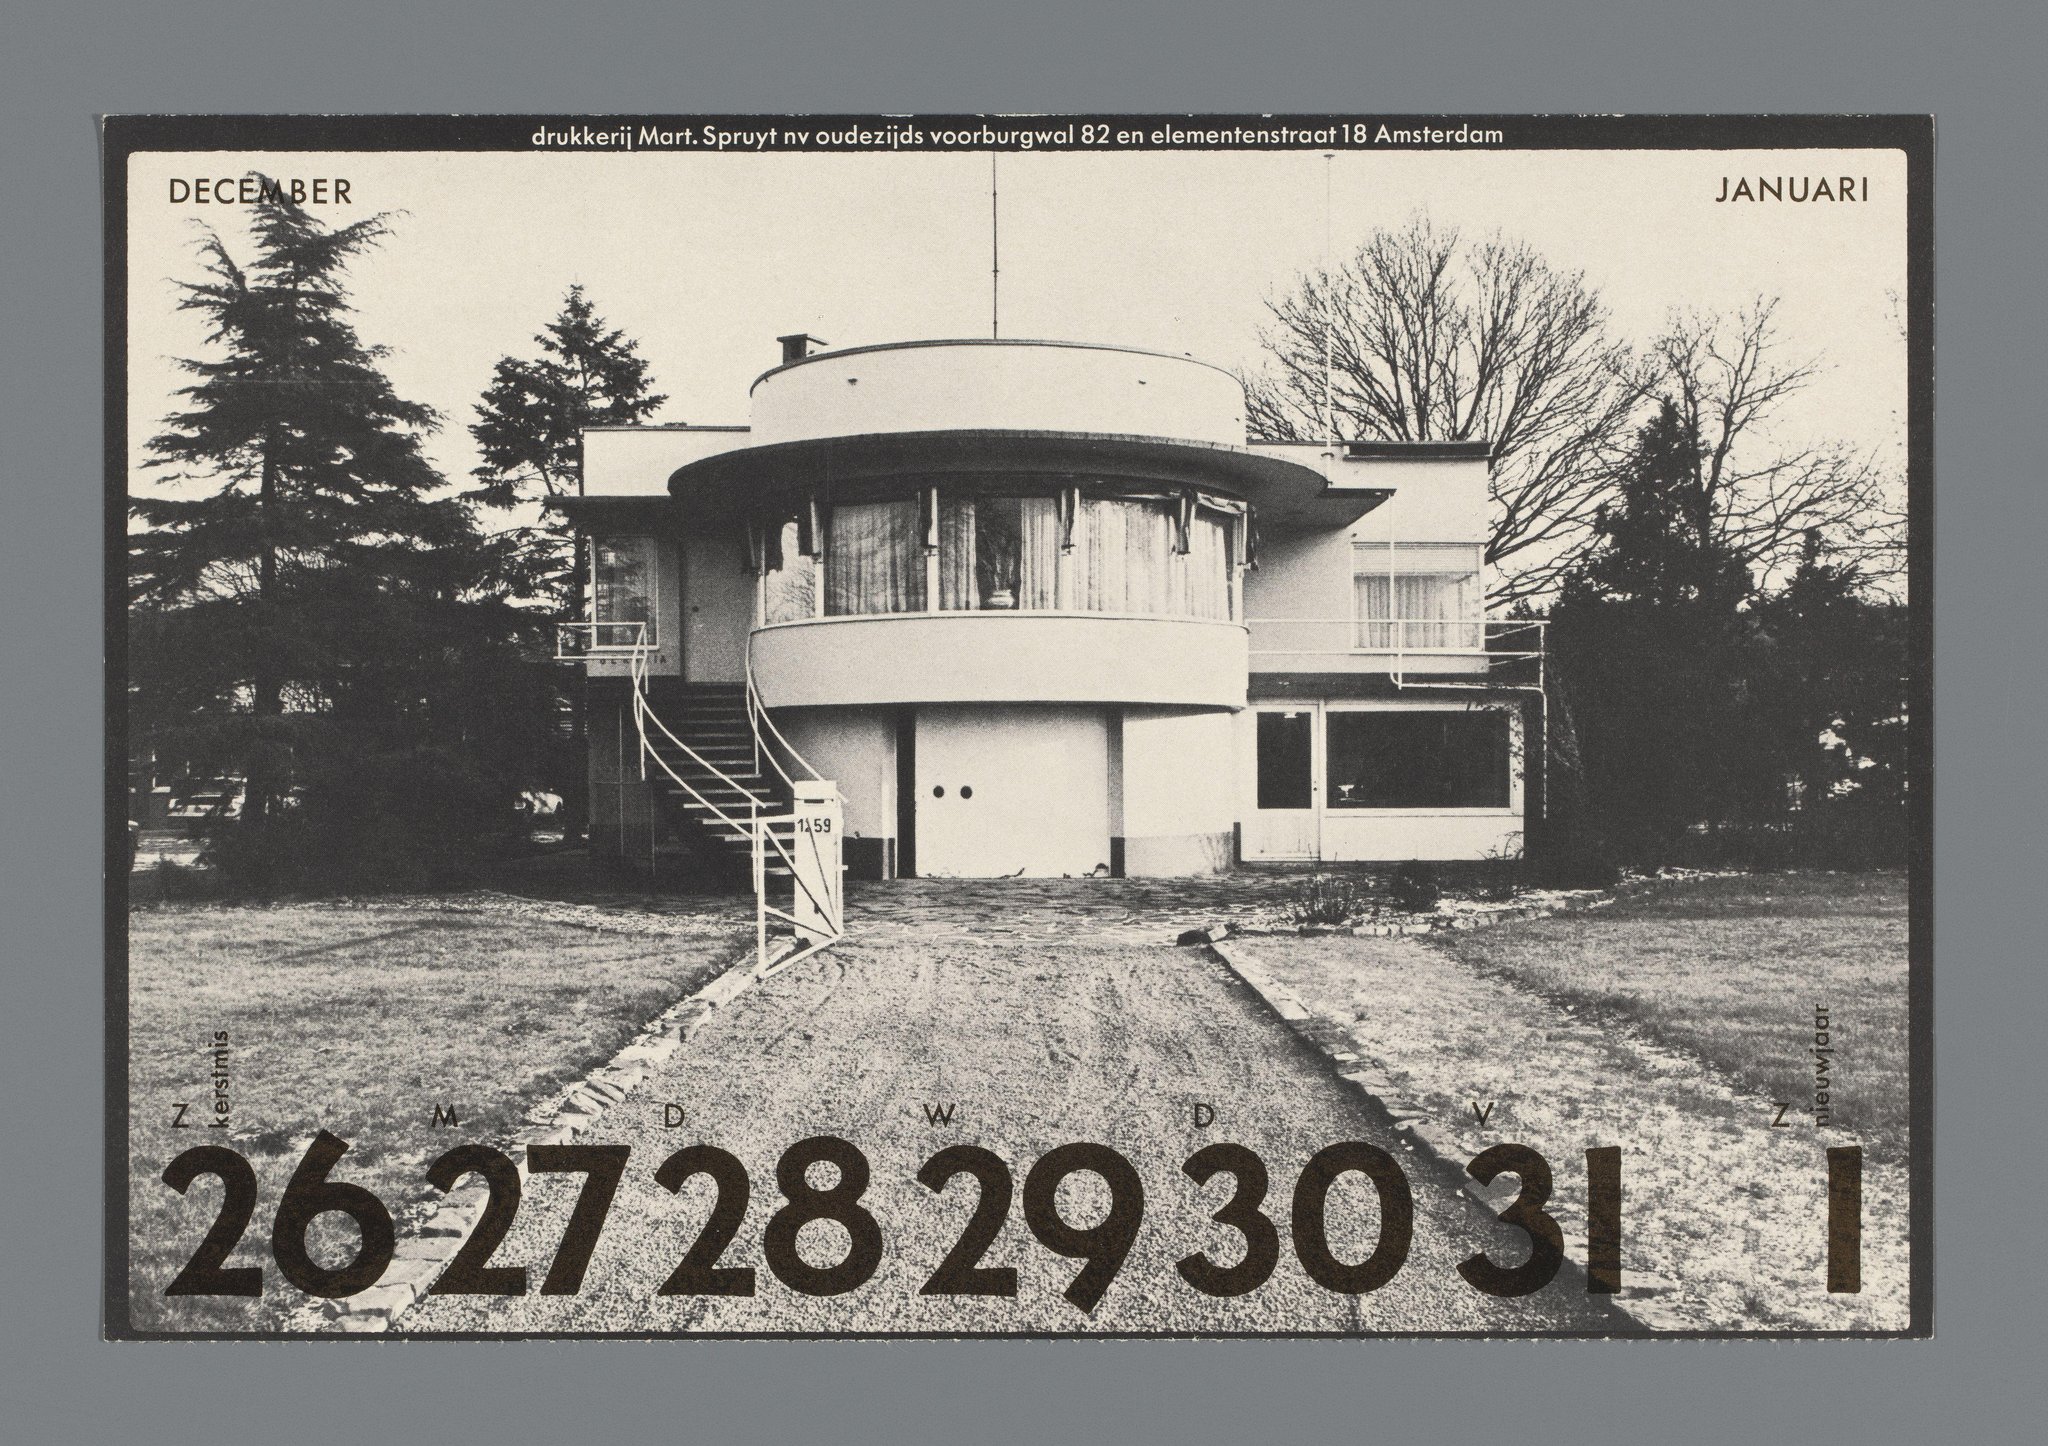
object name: photograph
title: België. Huizen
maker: Anonymous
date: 1900-1950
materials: paper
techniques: offset printed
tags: belgium